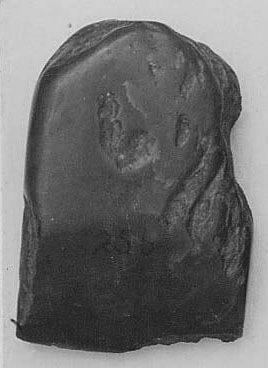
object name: adze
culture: north american, alaskan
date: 1902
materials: jade